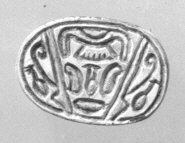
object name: stamp seal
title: Scarab seal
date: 1700-1560 BCE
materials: stone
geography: levant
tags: scarabs